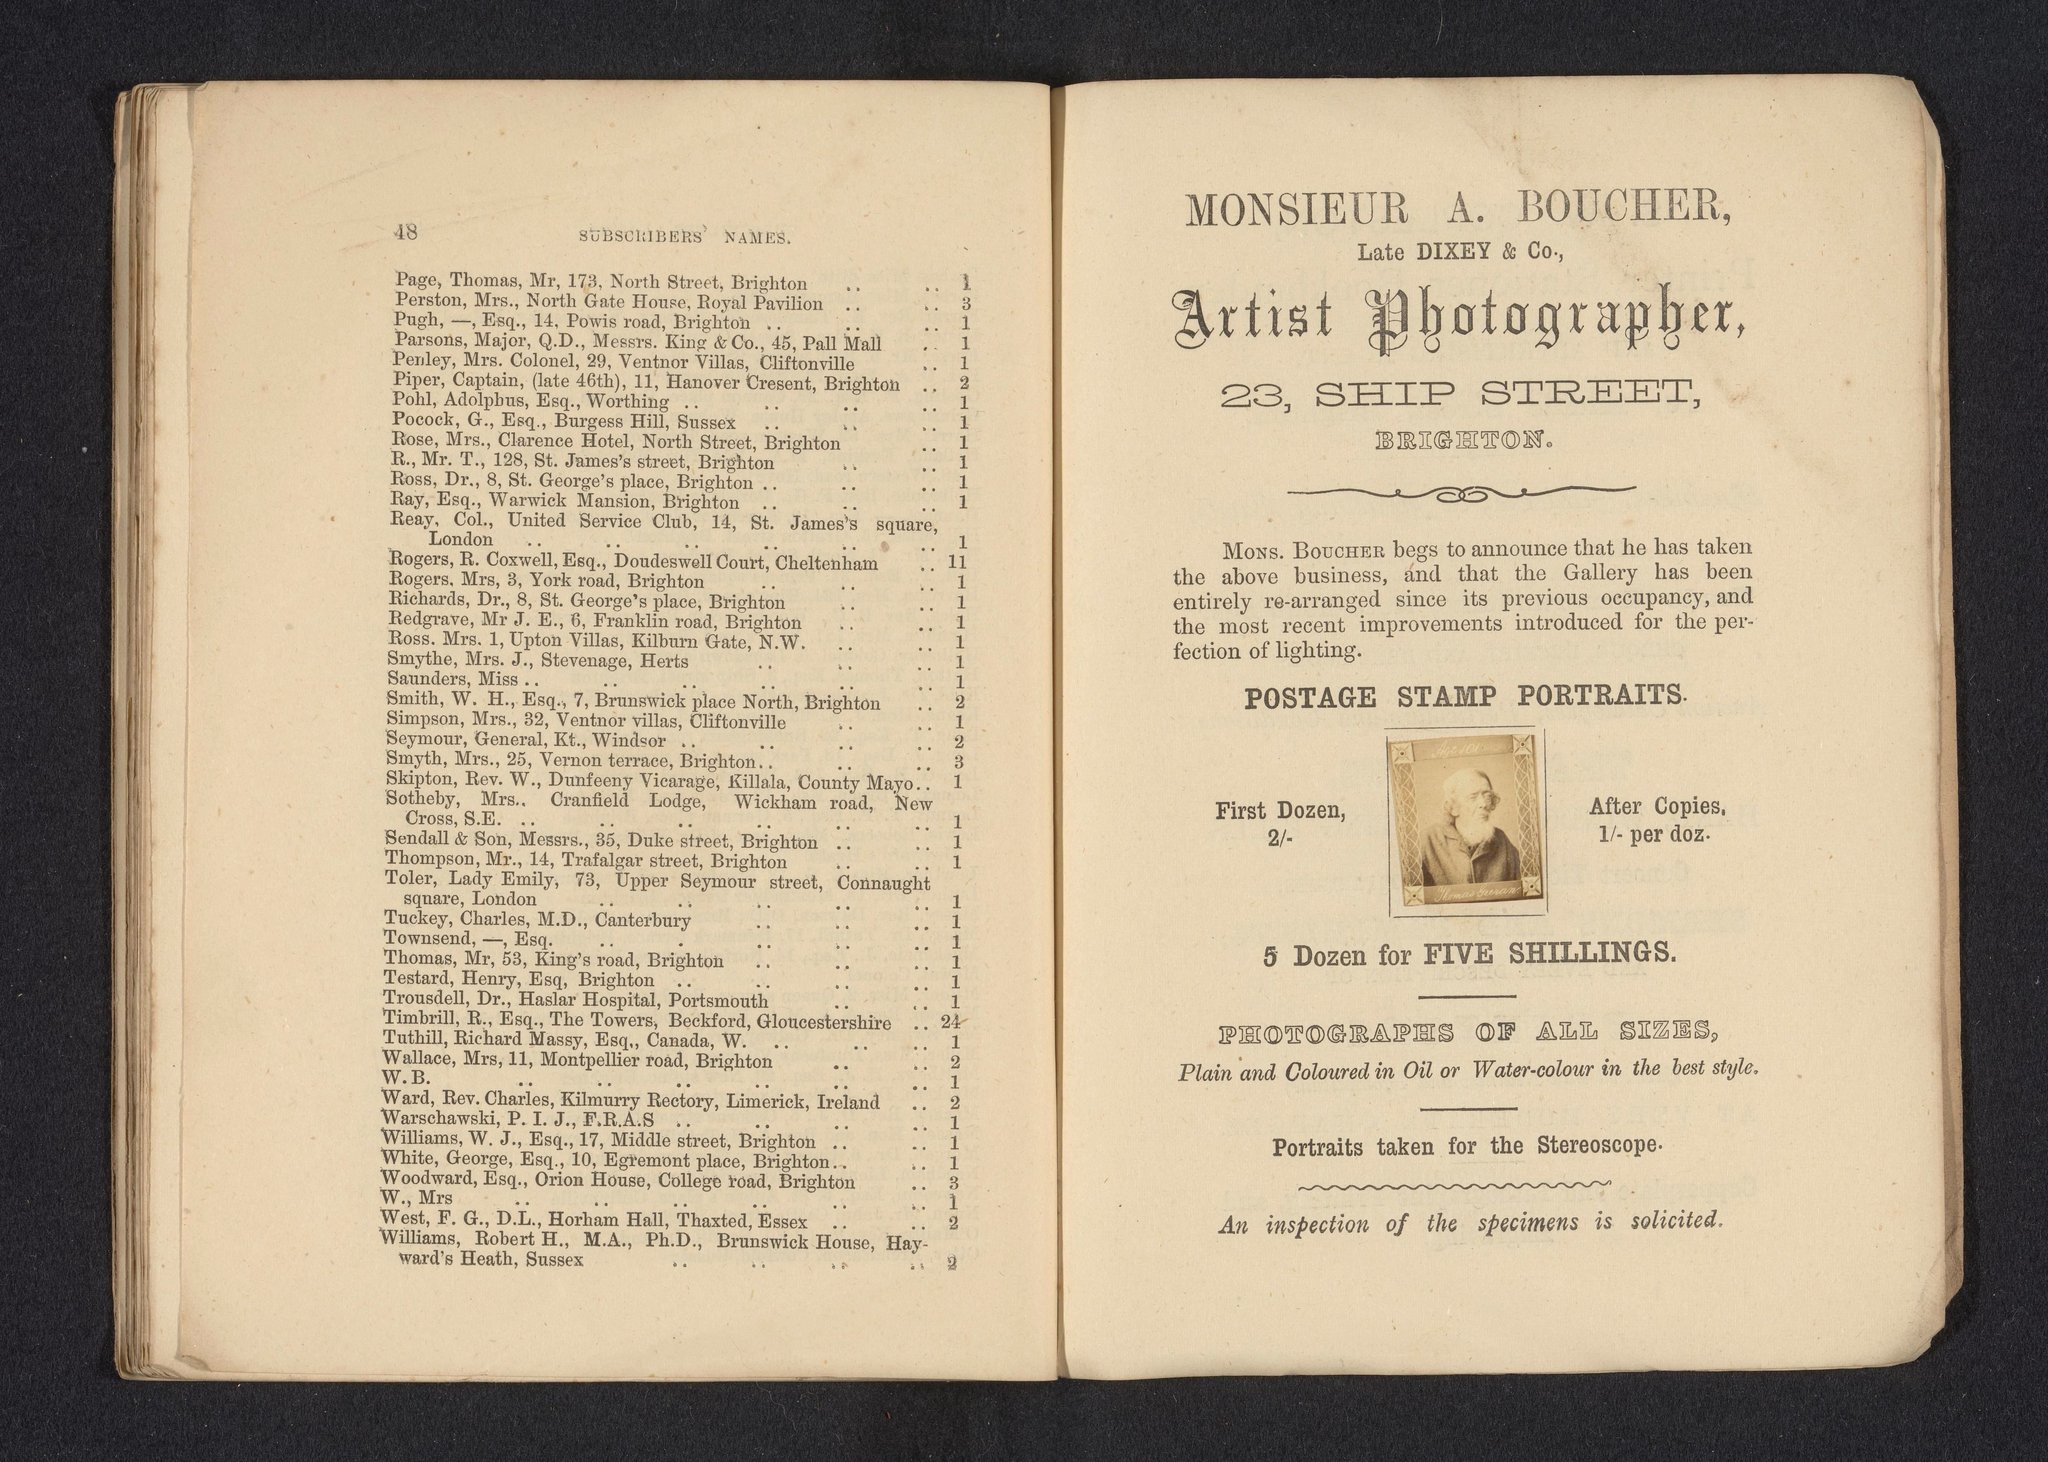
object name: photograph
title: Portret van Thomas Geeran, uitgevoerd als postzegel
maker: albert boucher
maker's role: fotograaf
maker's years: 1841-1875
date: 1870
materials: photographic support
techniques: albumen print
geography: brighton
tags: stamp (~ postal matter), old man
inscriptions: inscription: ‘Monsieur A. Boucher (...) An inspection of the specimens is sollicited.’